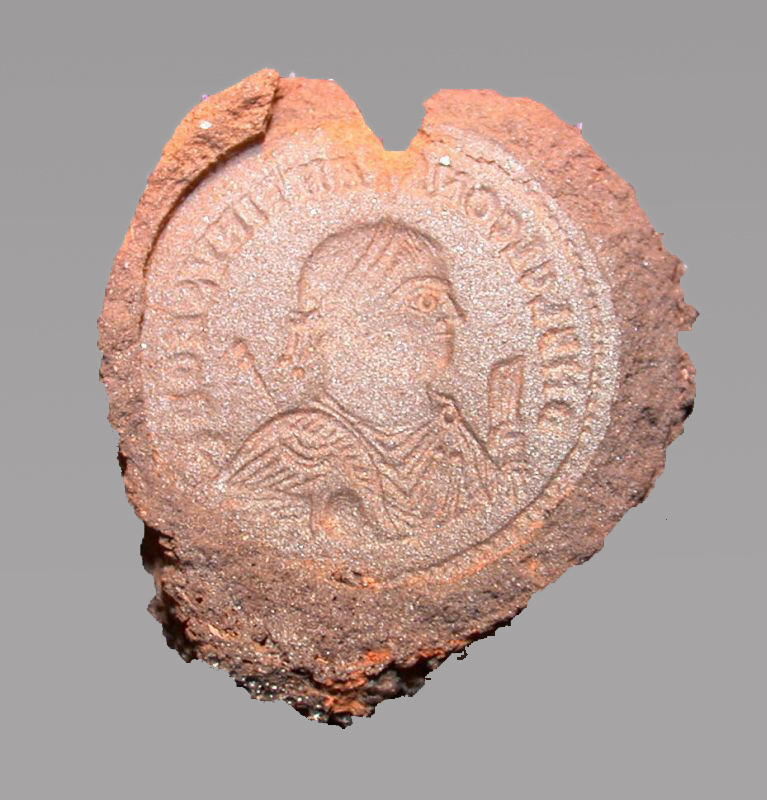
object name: mold of forgery of roman coin of 3rd century a. d., 8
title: Terracotta coin molds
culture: roman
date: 308-320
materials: terracotta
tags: men,profiles